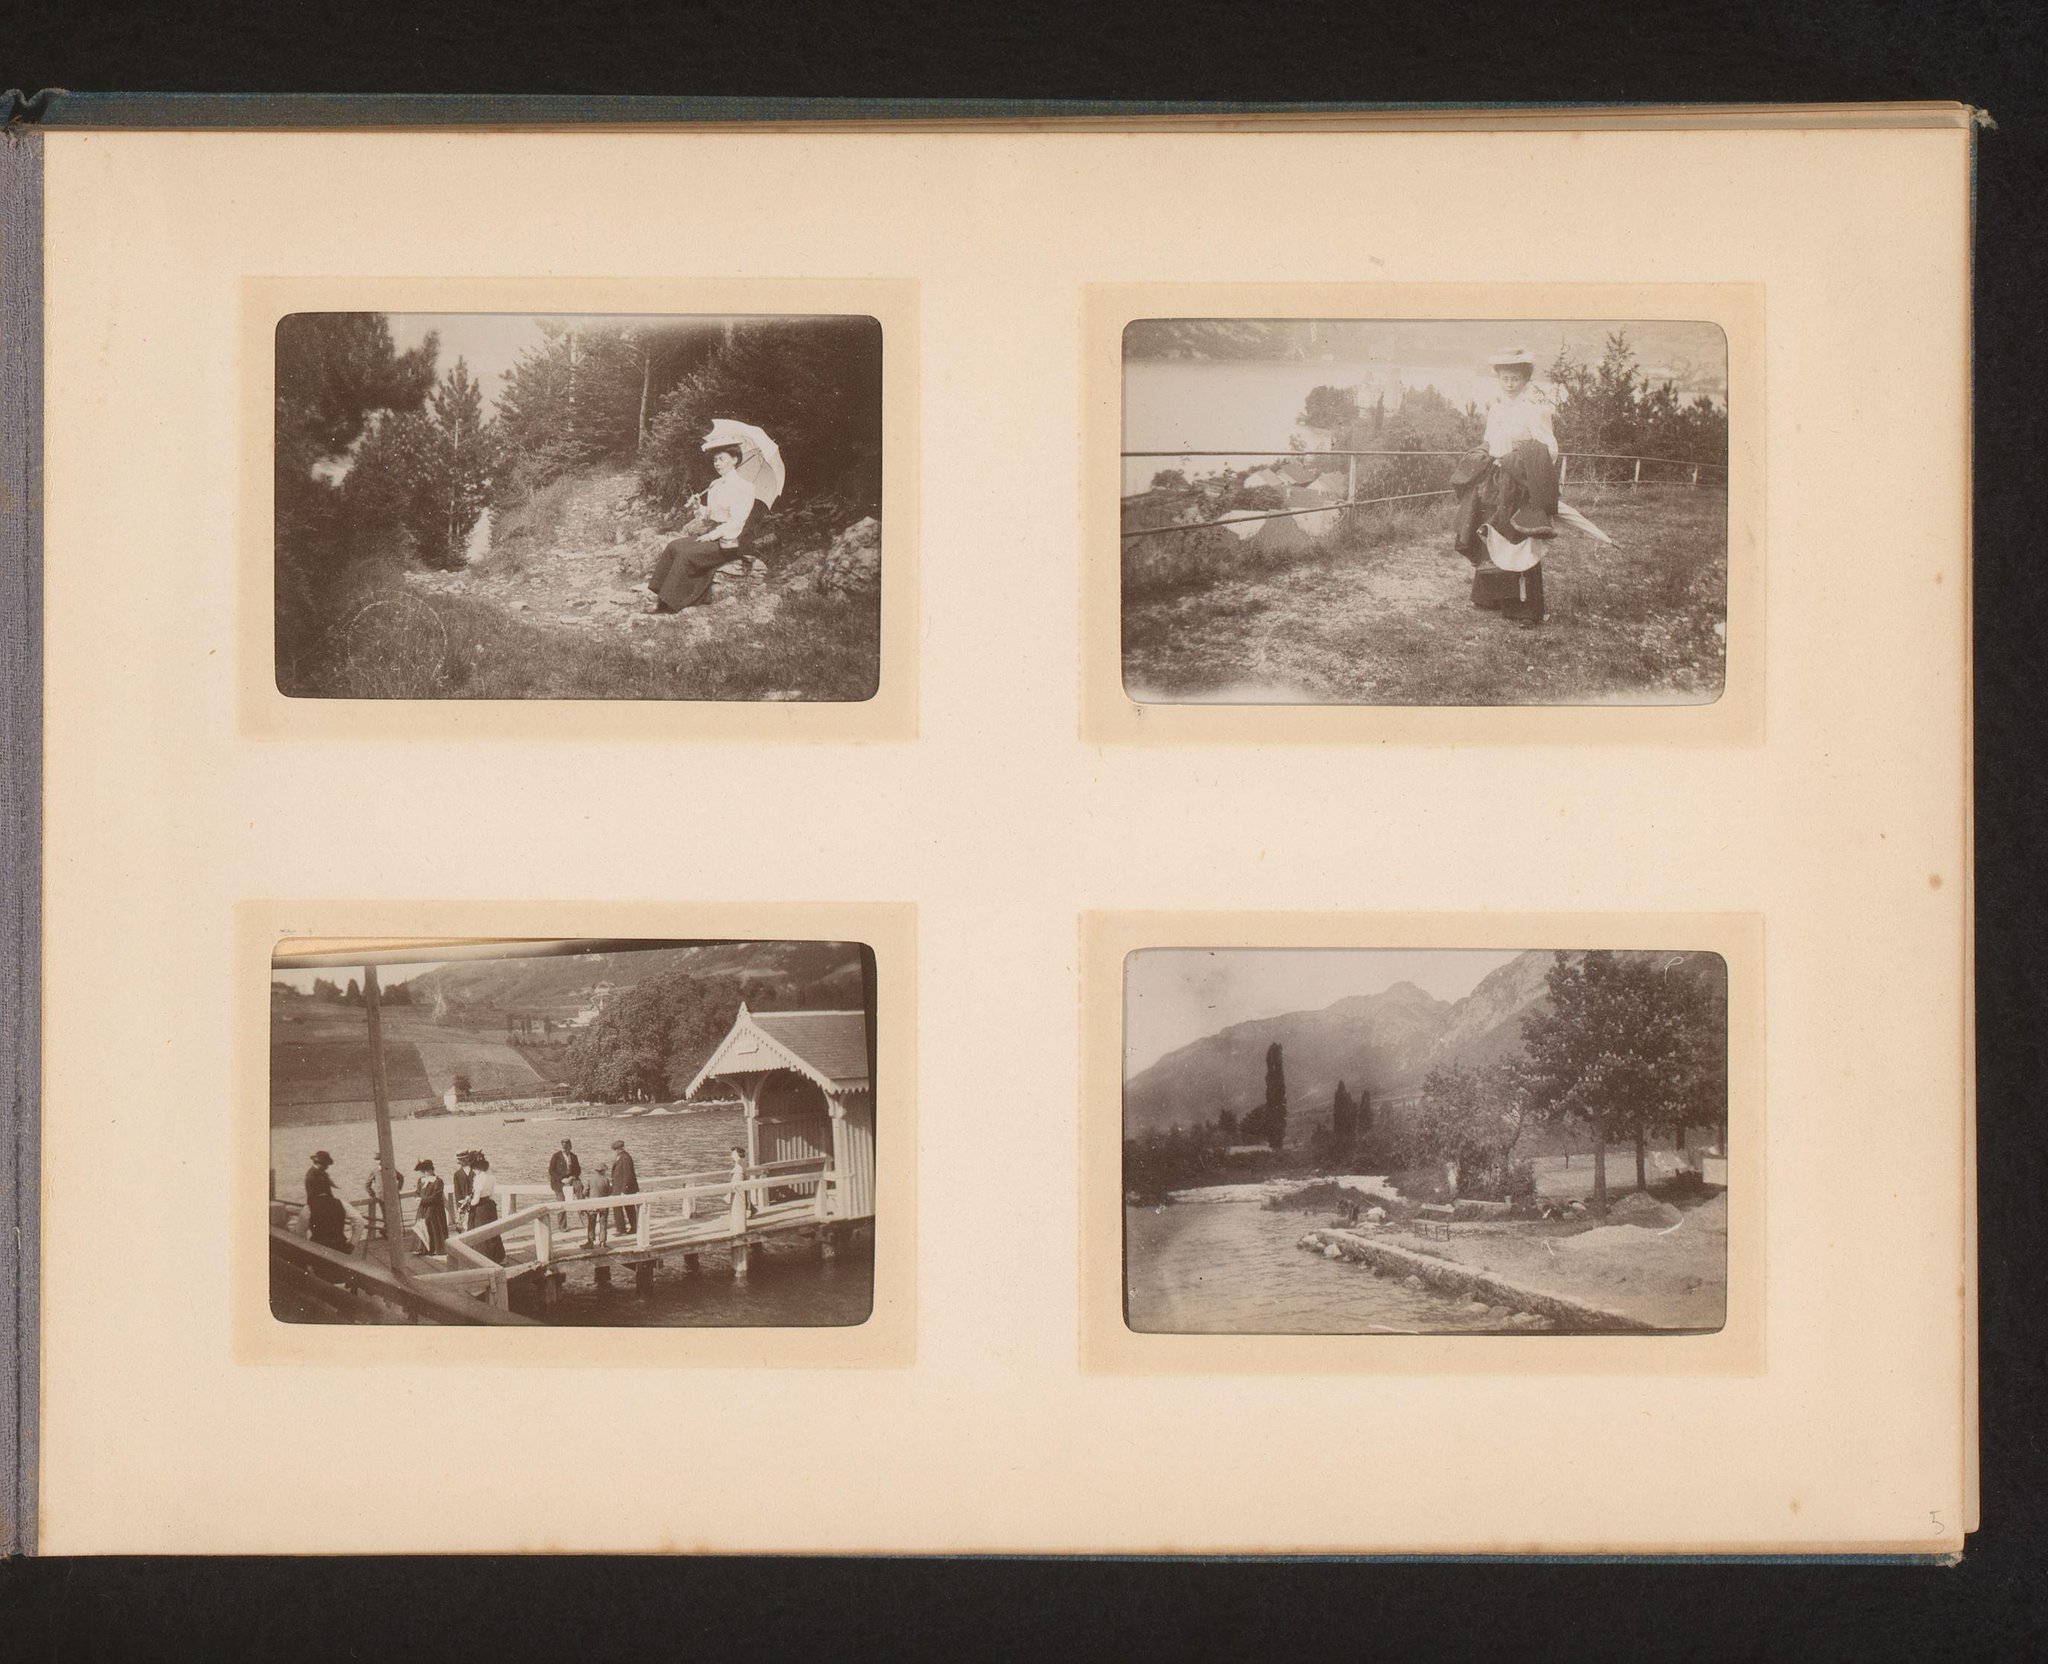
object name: photograph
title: Twee opnamen van een vrouw in een landschap te Frankrijk en twee landschappen met water te Frankrijk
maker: Anonymous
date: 1900-1915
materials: paper, photographic support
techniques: gelatin silver print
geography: france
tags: adult woman, landscapes with waters, waterscapes, seascapes (in the temperate zone), travelling; tourism, france